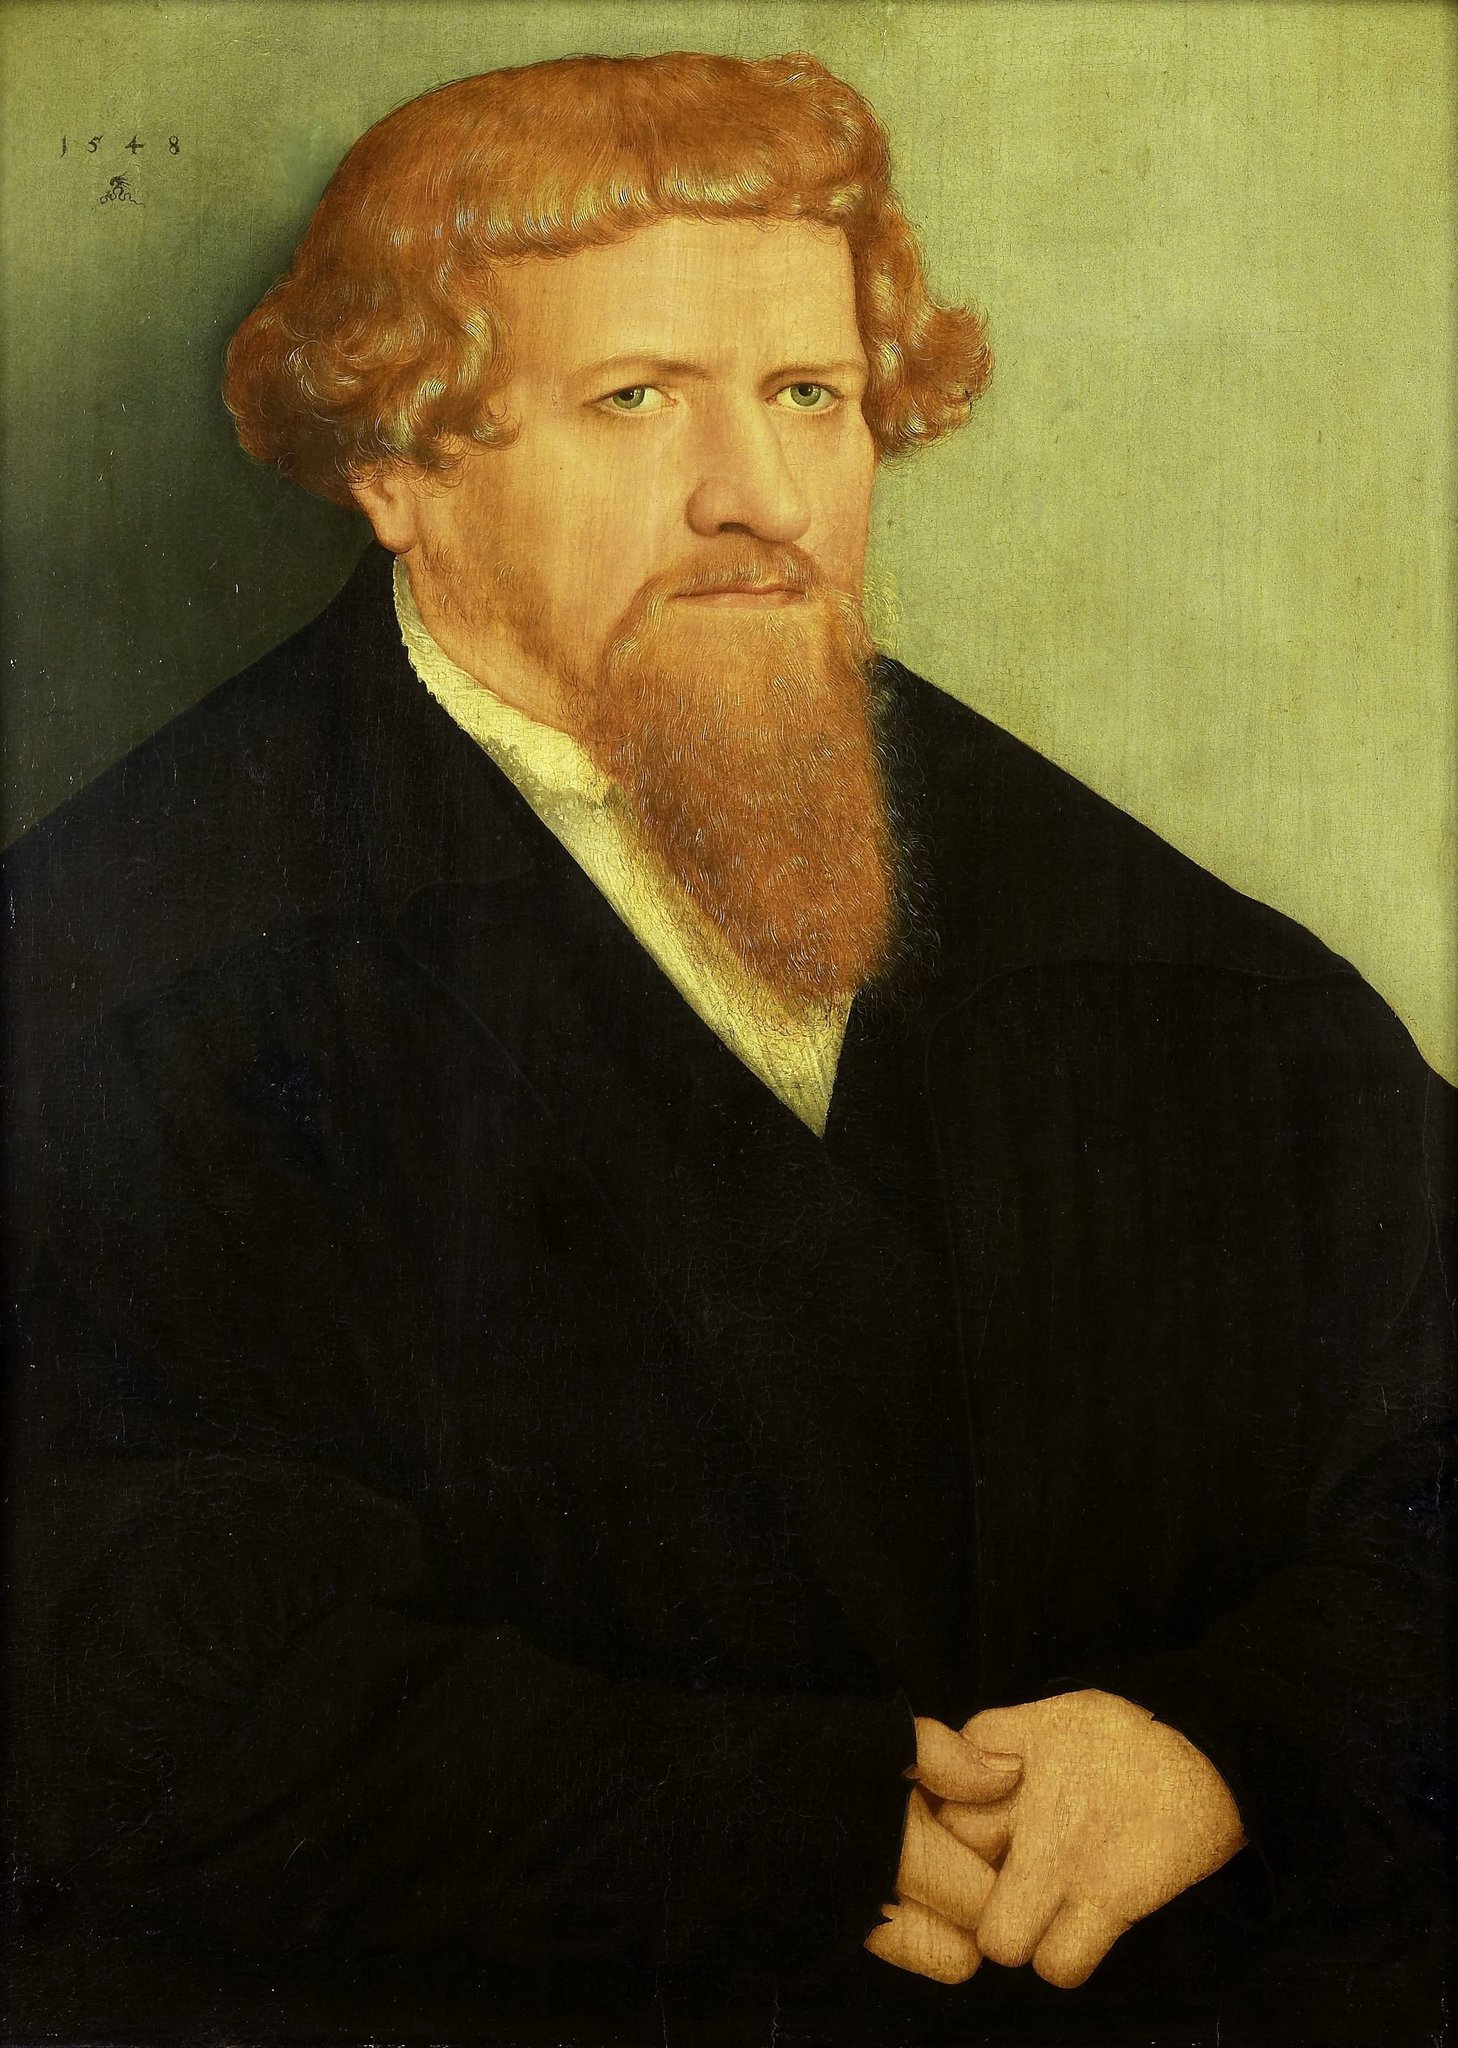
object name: painting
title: Portrait of a Man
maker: lucas cranach (ii)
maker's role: print maker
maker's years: 1515-1586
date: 1548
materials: oil, panel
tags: historical persons not known by name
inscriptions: signature and date: ‘1548’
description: Portret van een man met een lange baard, de handen in elkaar op de buik